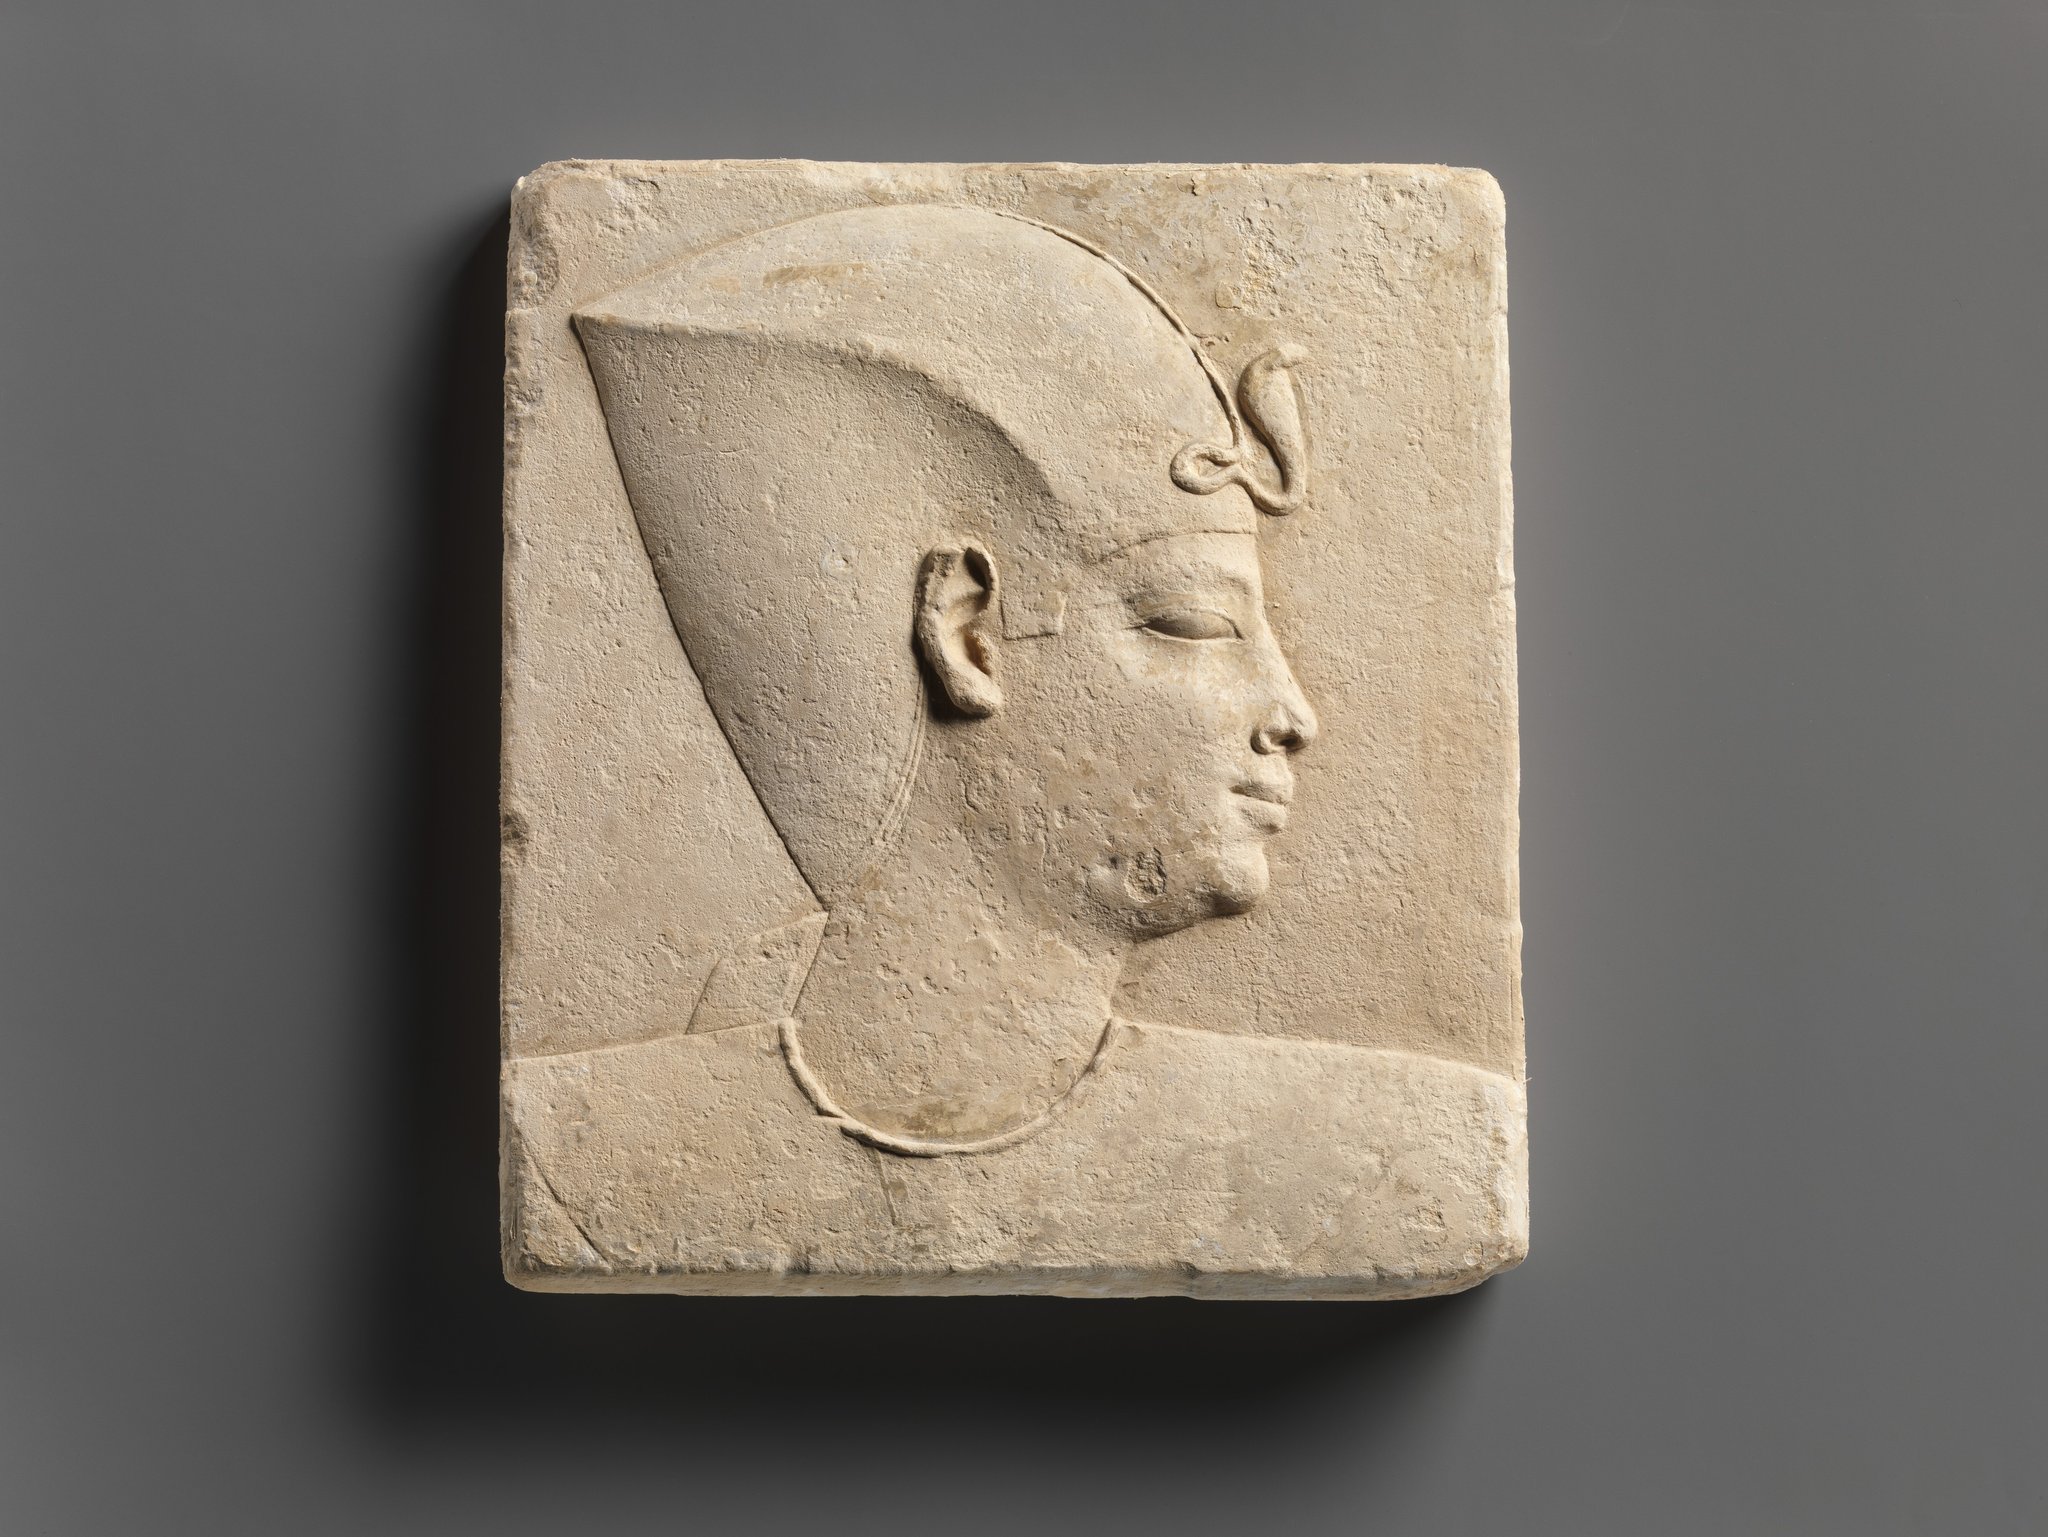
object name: sculptor's model votive, king, blue crown, child god on opposite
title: Relief of king's head in blue crown, head of child god on opposite side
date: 400-200 BCE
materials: limestone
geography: egypt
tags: kings,heads